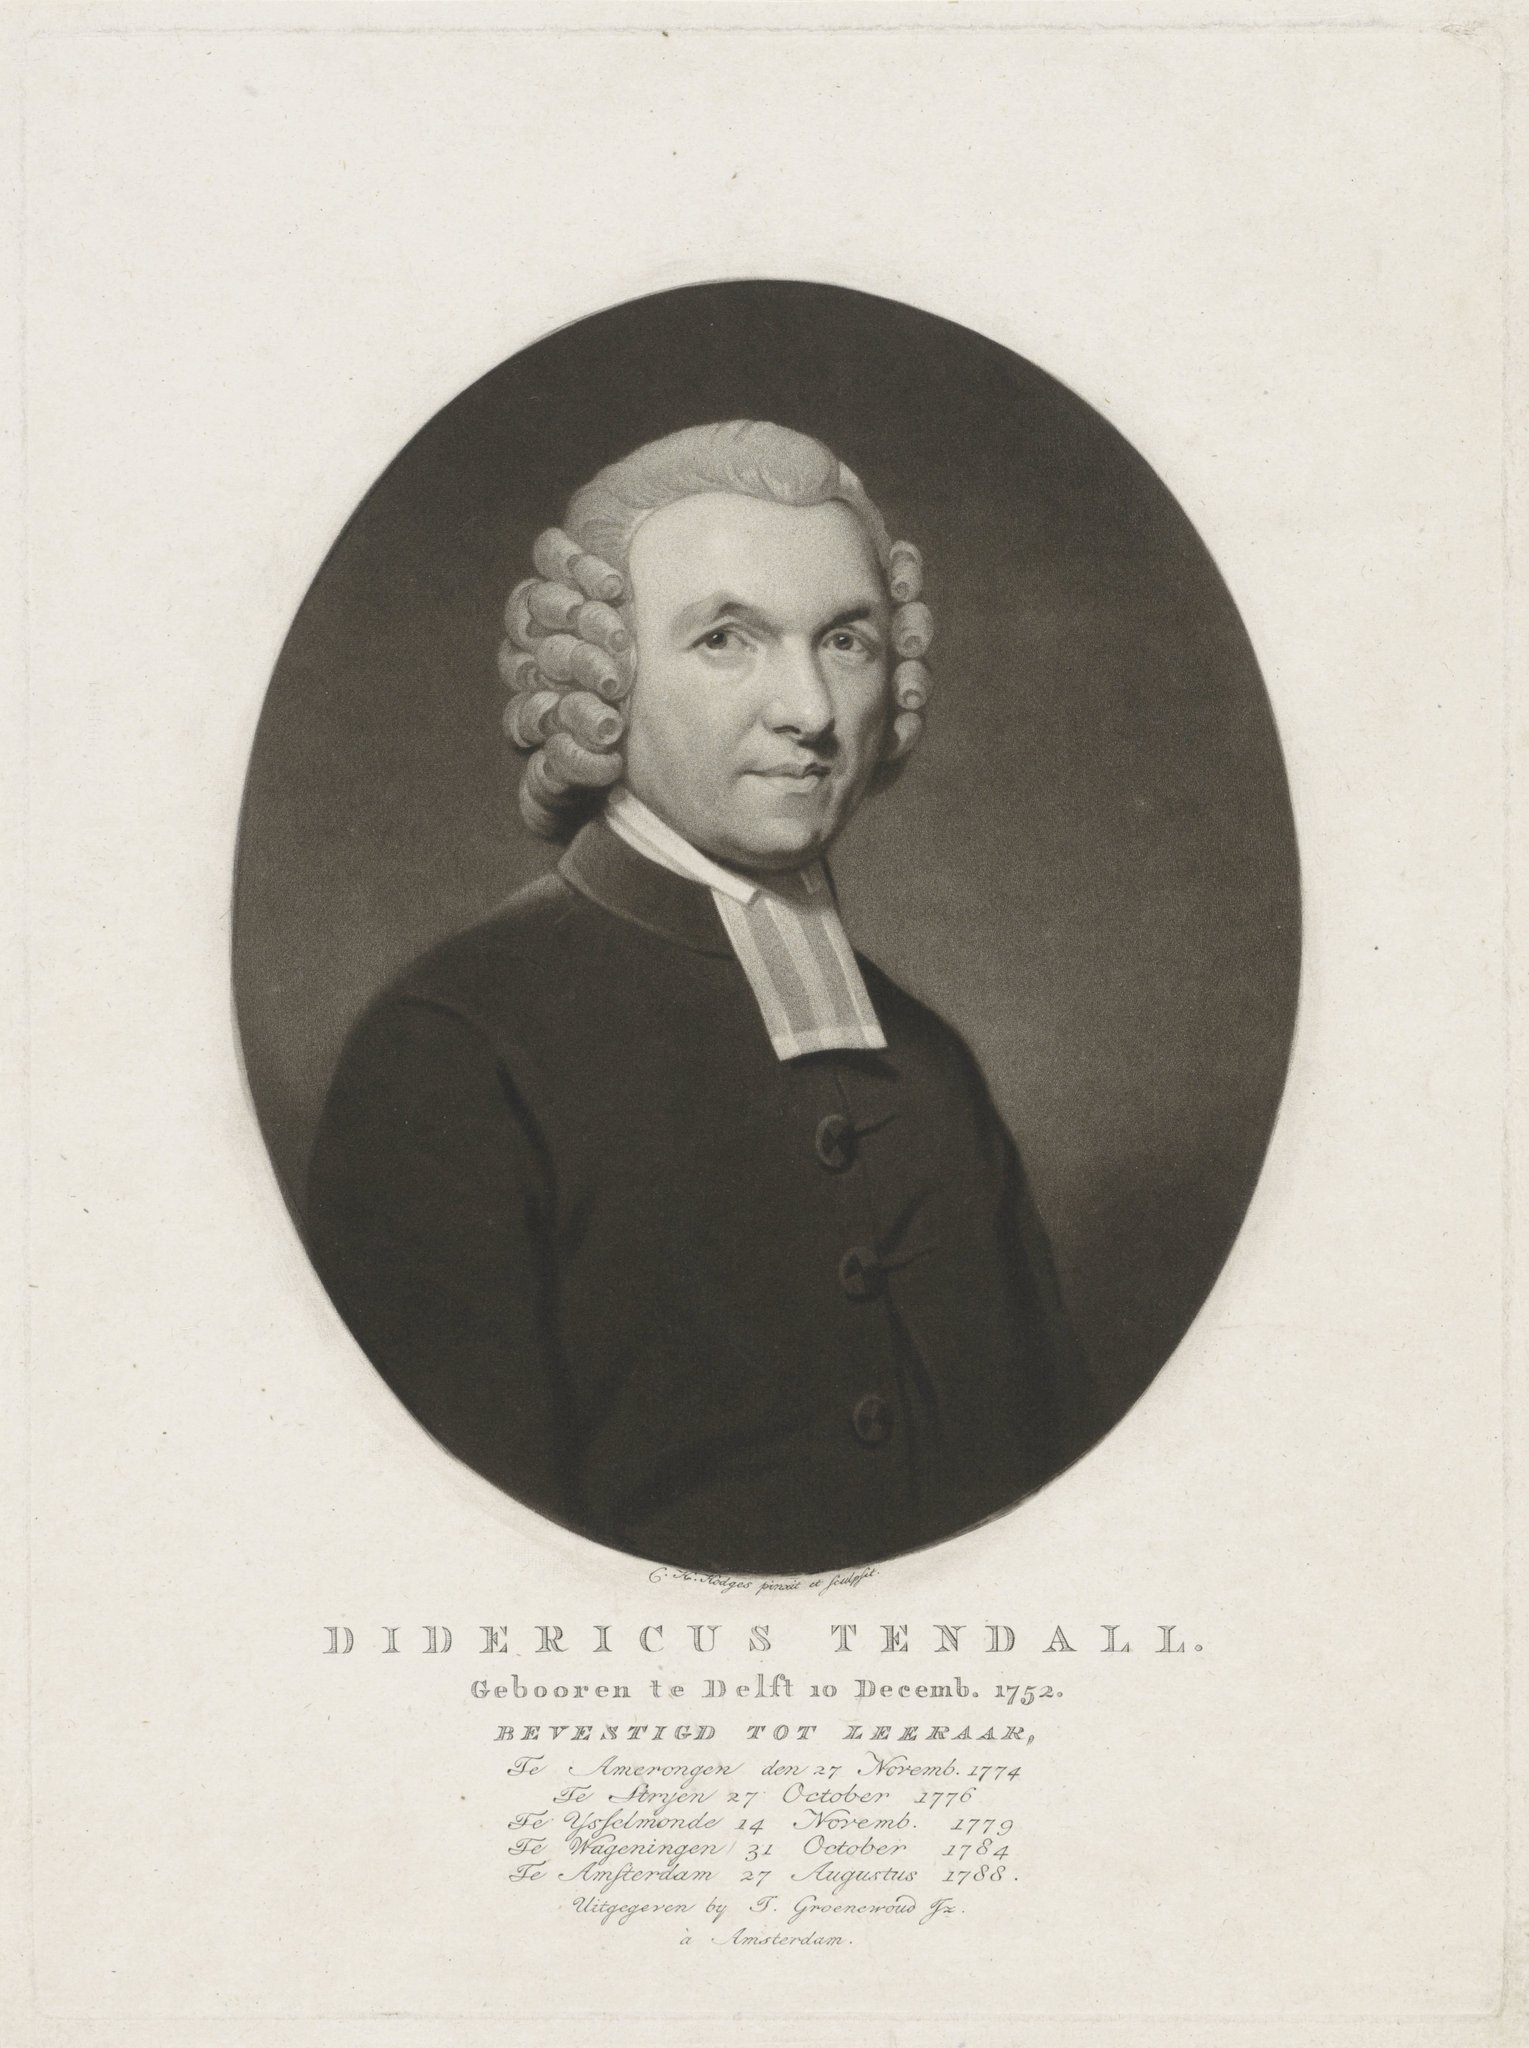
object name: print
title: Portret van de predikant Didericus Tendall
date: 1804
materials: paper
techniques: engraving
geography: amsterdam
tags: delft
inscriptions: collector's mark: Lugt 2228